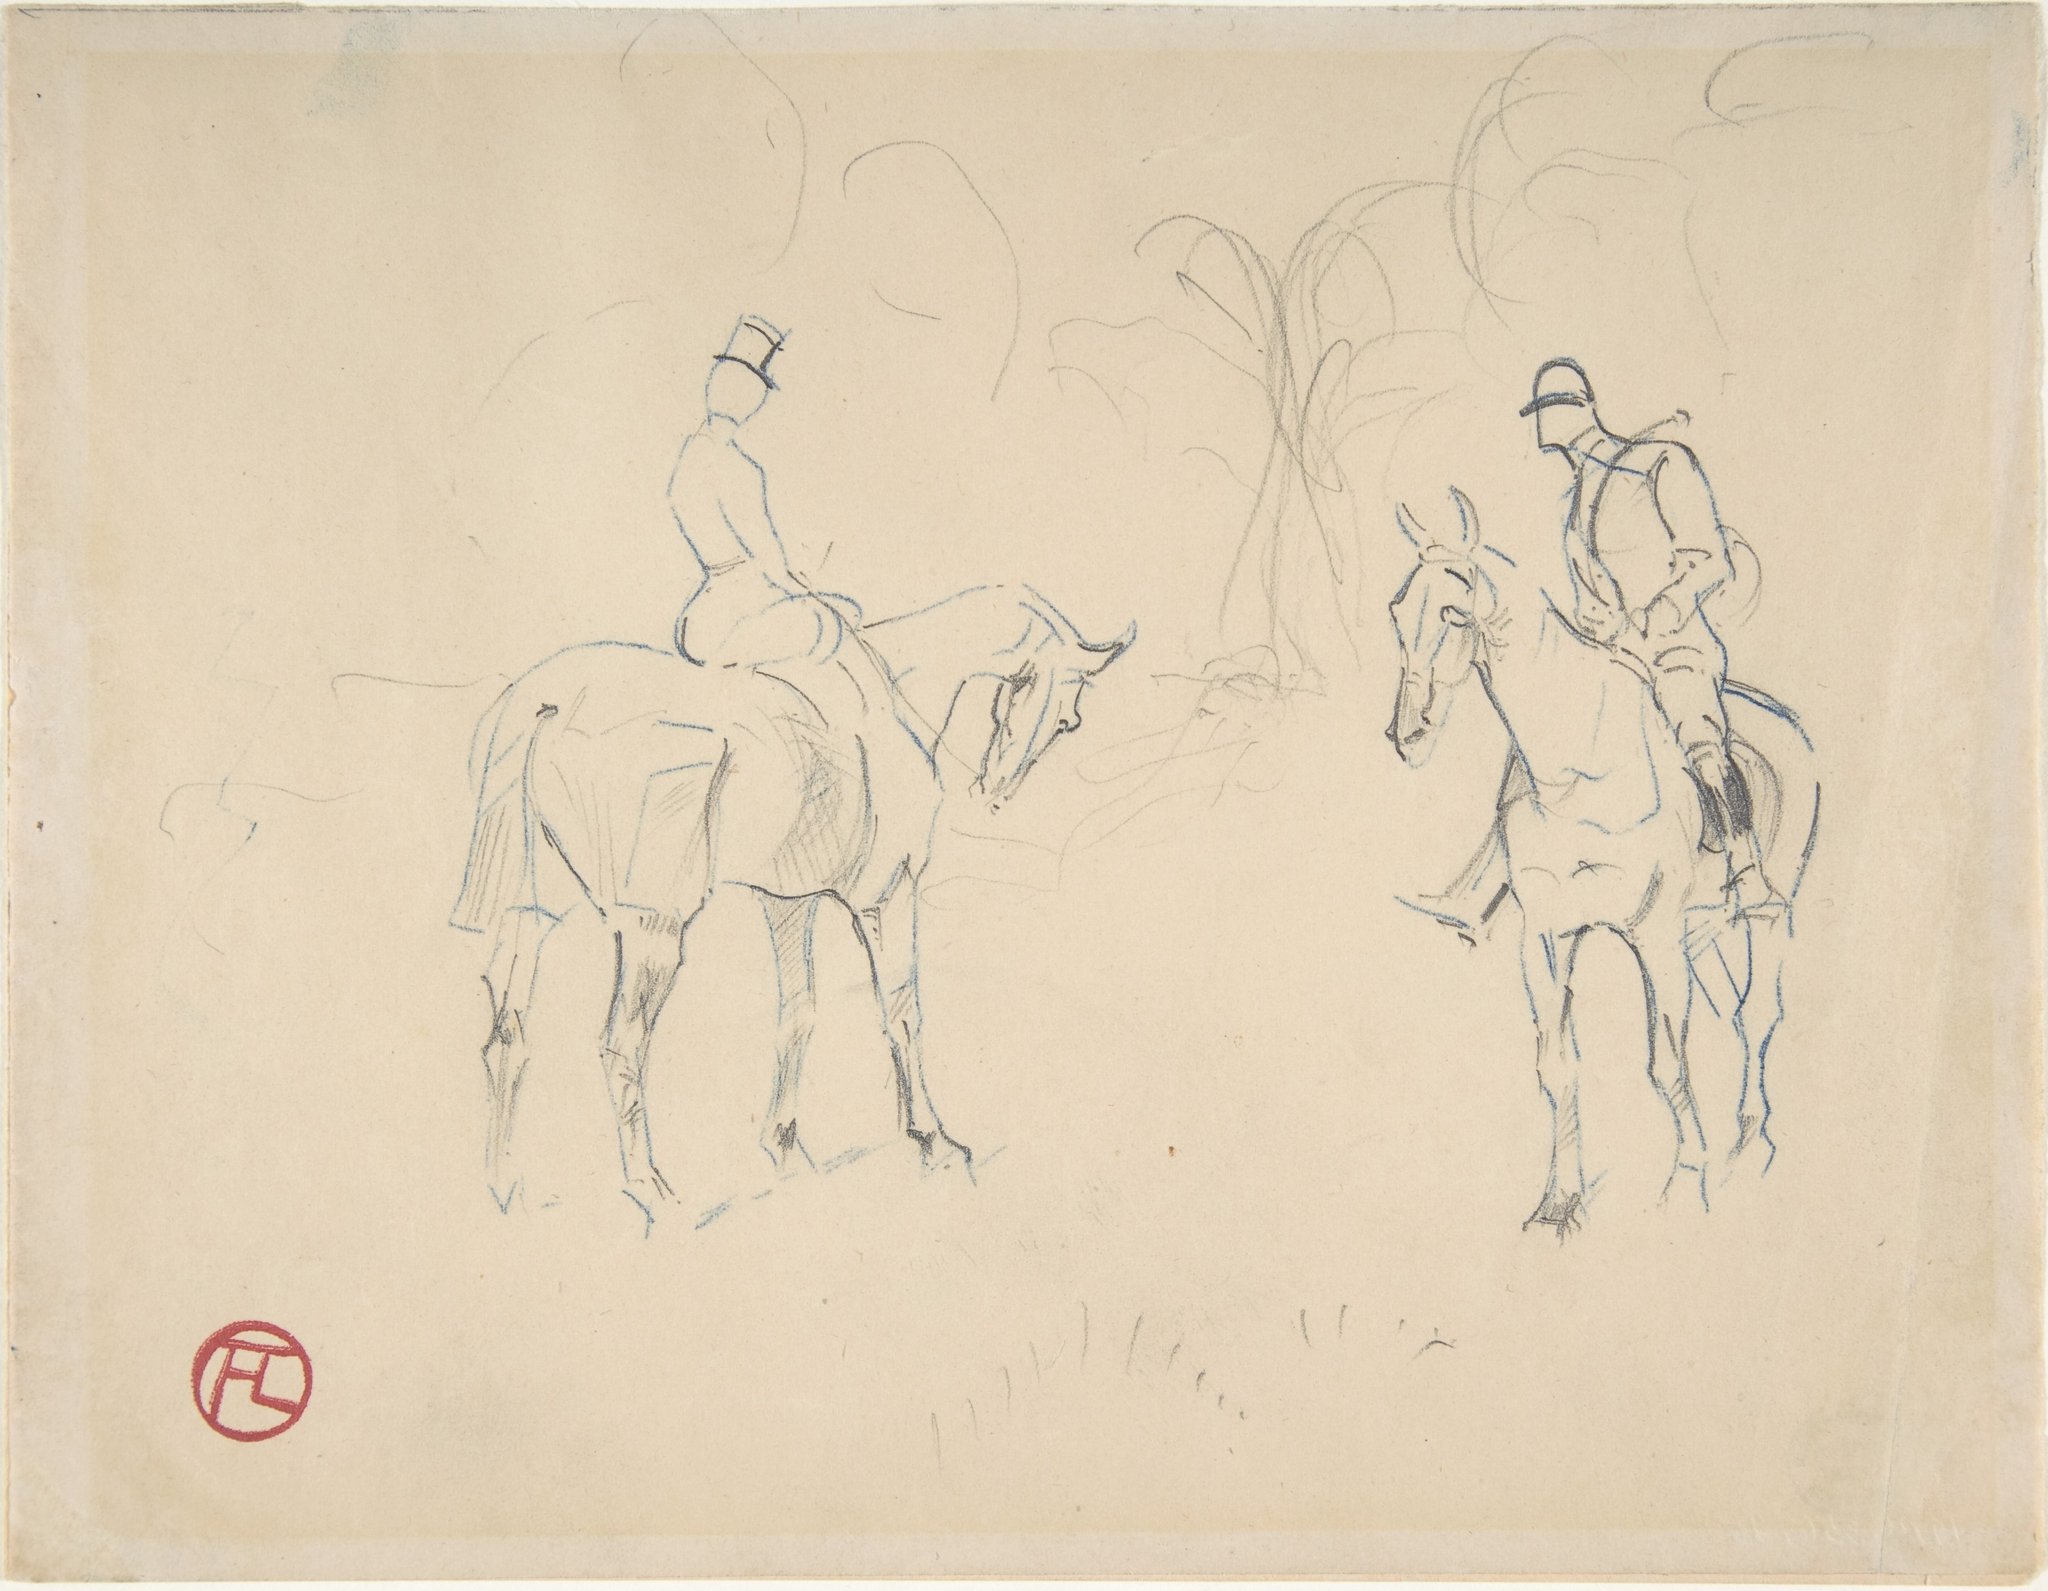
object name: drawing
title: A Woman and a Man on Horseback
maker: henri de toulouse-lautrec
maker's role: artist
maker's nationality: french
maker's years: 1864-1901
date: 1879-1881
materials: crayon, graphite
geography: france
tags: men,women,horses